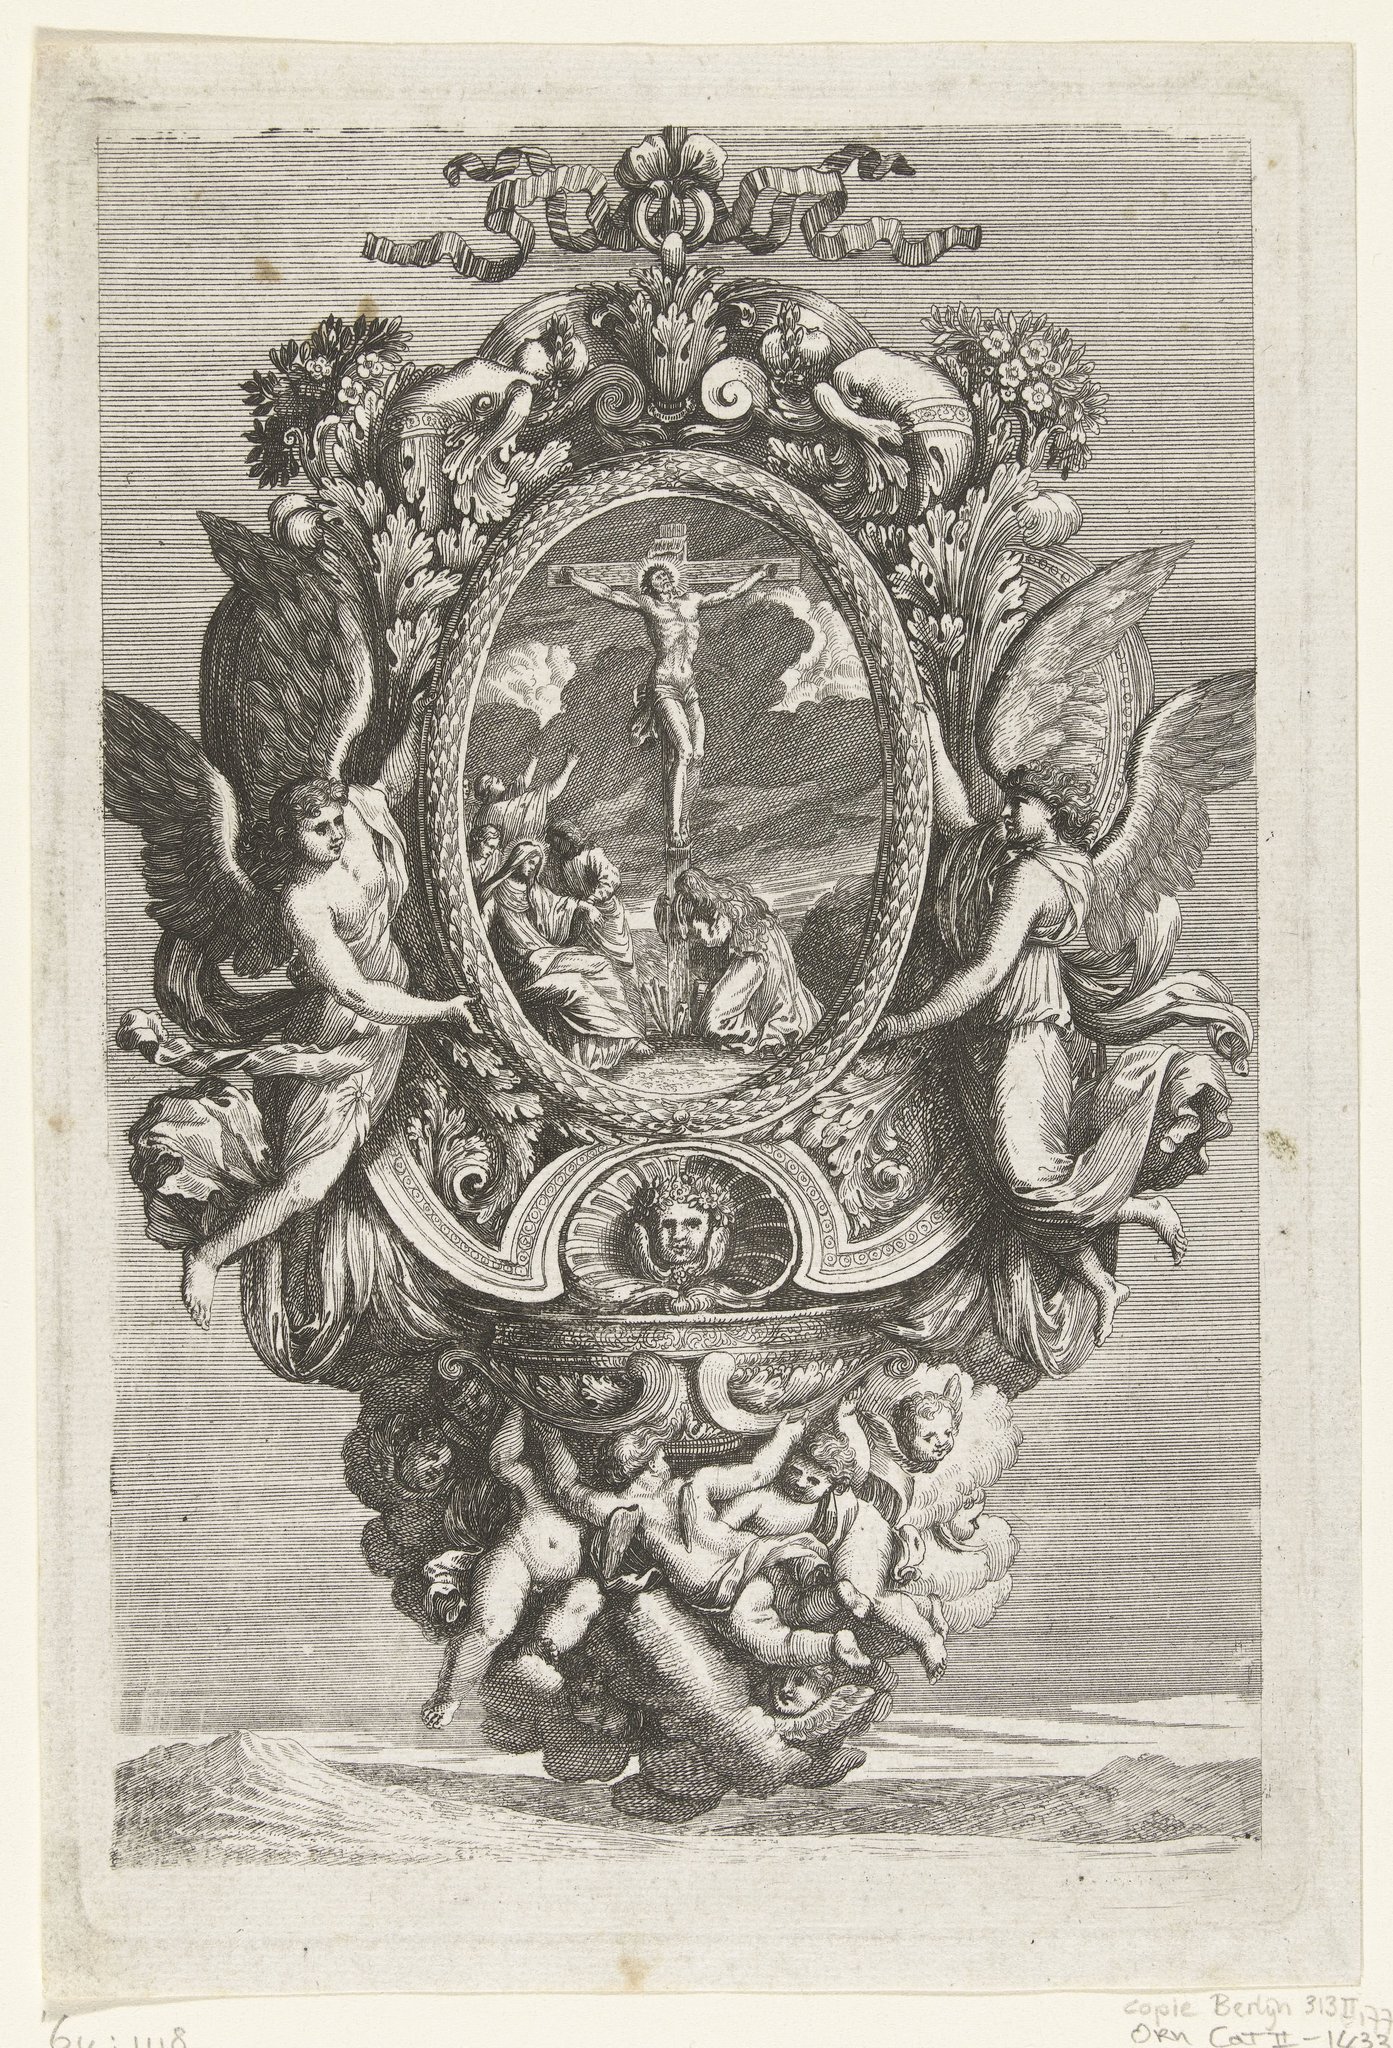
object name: print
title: Wijwaterbak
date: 1677-1692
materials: paper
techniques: etching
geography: antwerp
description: De wijwaterbak wordt ondersteund door drie putti en zes cherubijnen. De achterplaat wordt gevormd door een ovaal medaillon, vastgehouden door twee engelen, met Christus aan het kruis. Uit serie van 6 bladen.